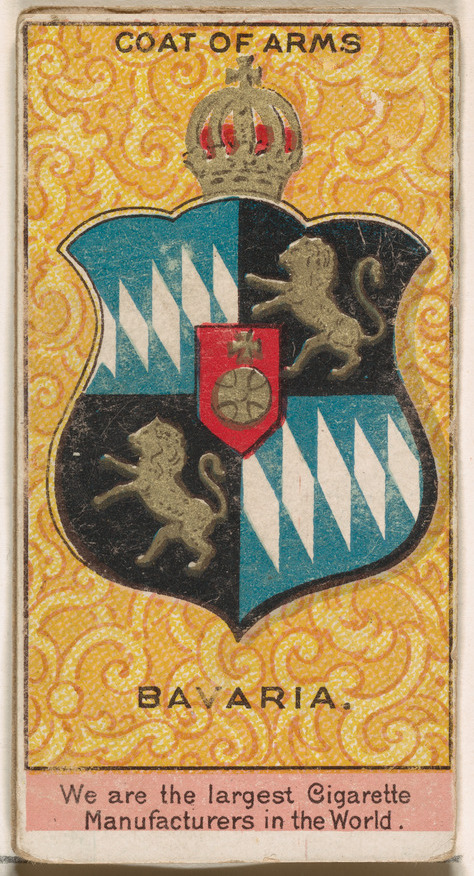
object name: print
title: Luitpold, Regent of Bavaria, from the Rulers, Flags, and Coats of Arms series (N126-2) issued by W. Duke, Sons & Co.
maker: w. duke, sons & co.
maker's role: publisher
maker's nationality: american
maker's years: 1870-1920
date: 1888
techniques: color lithograph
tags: men,portraits,coat of arms,flags